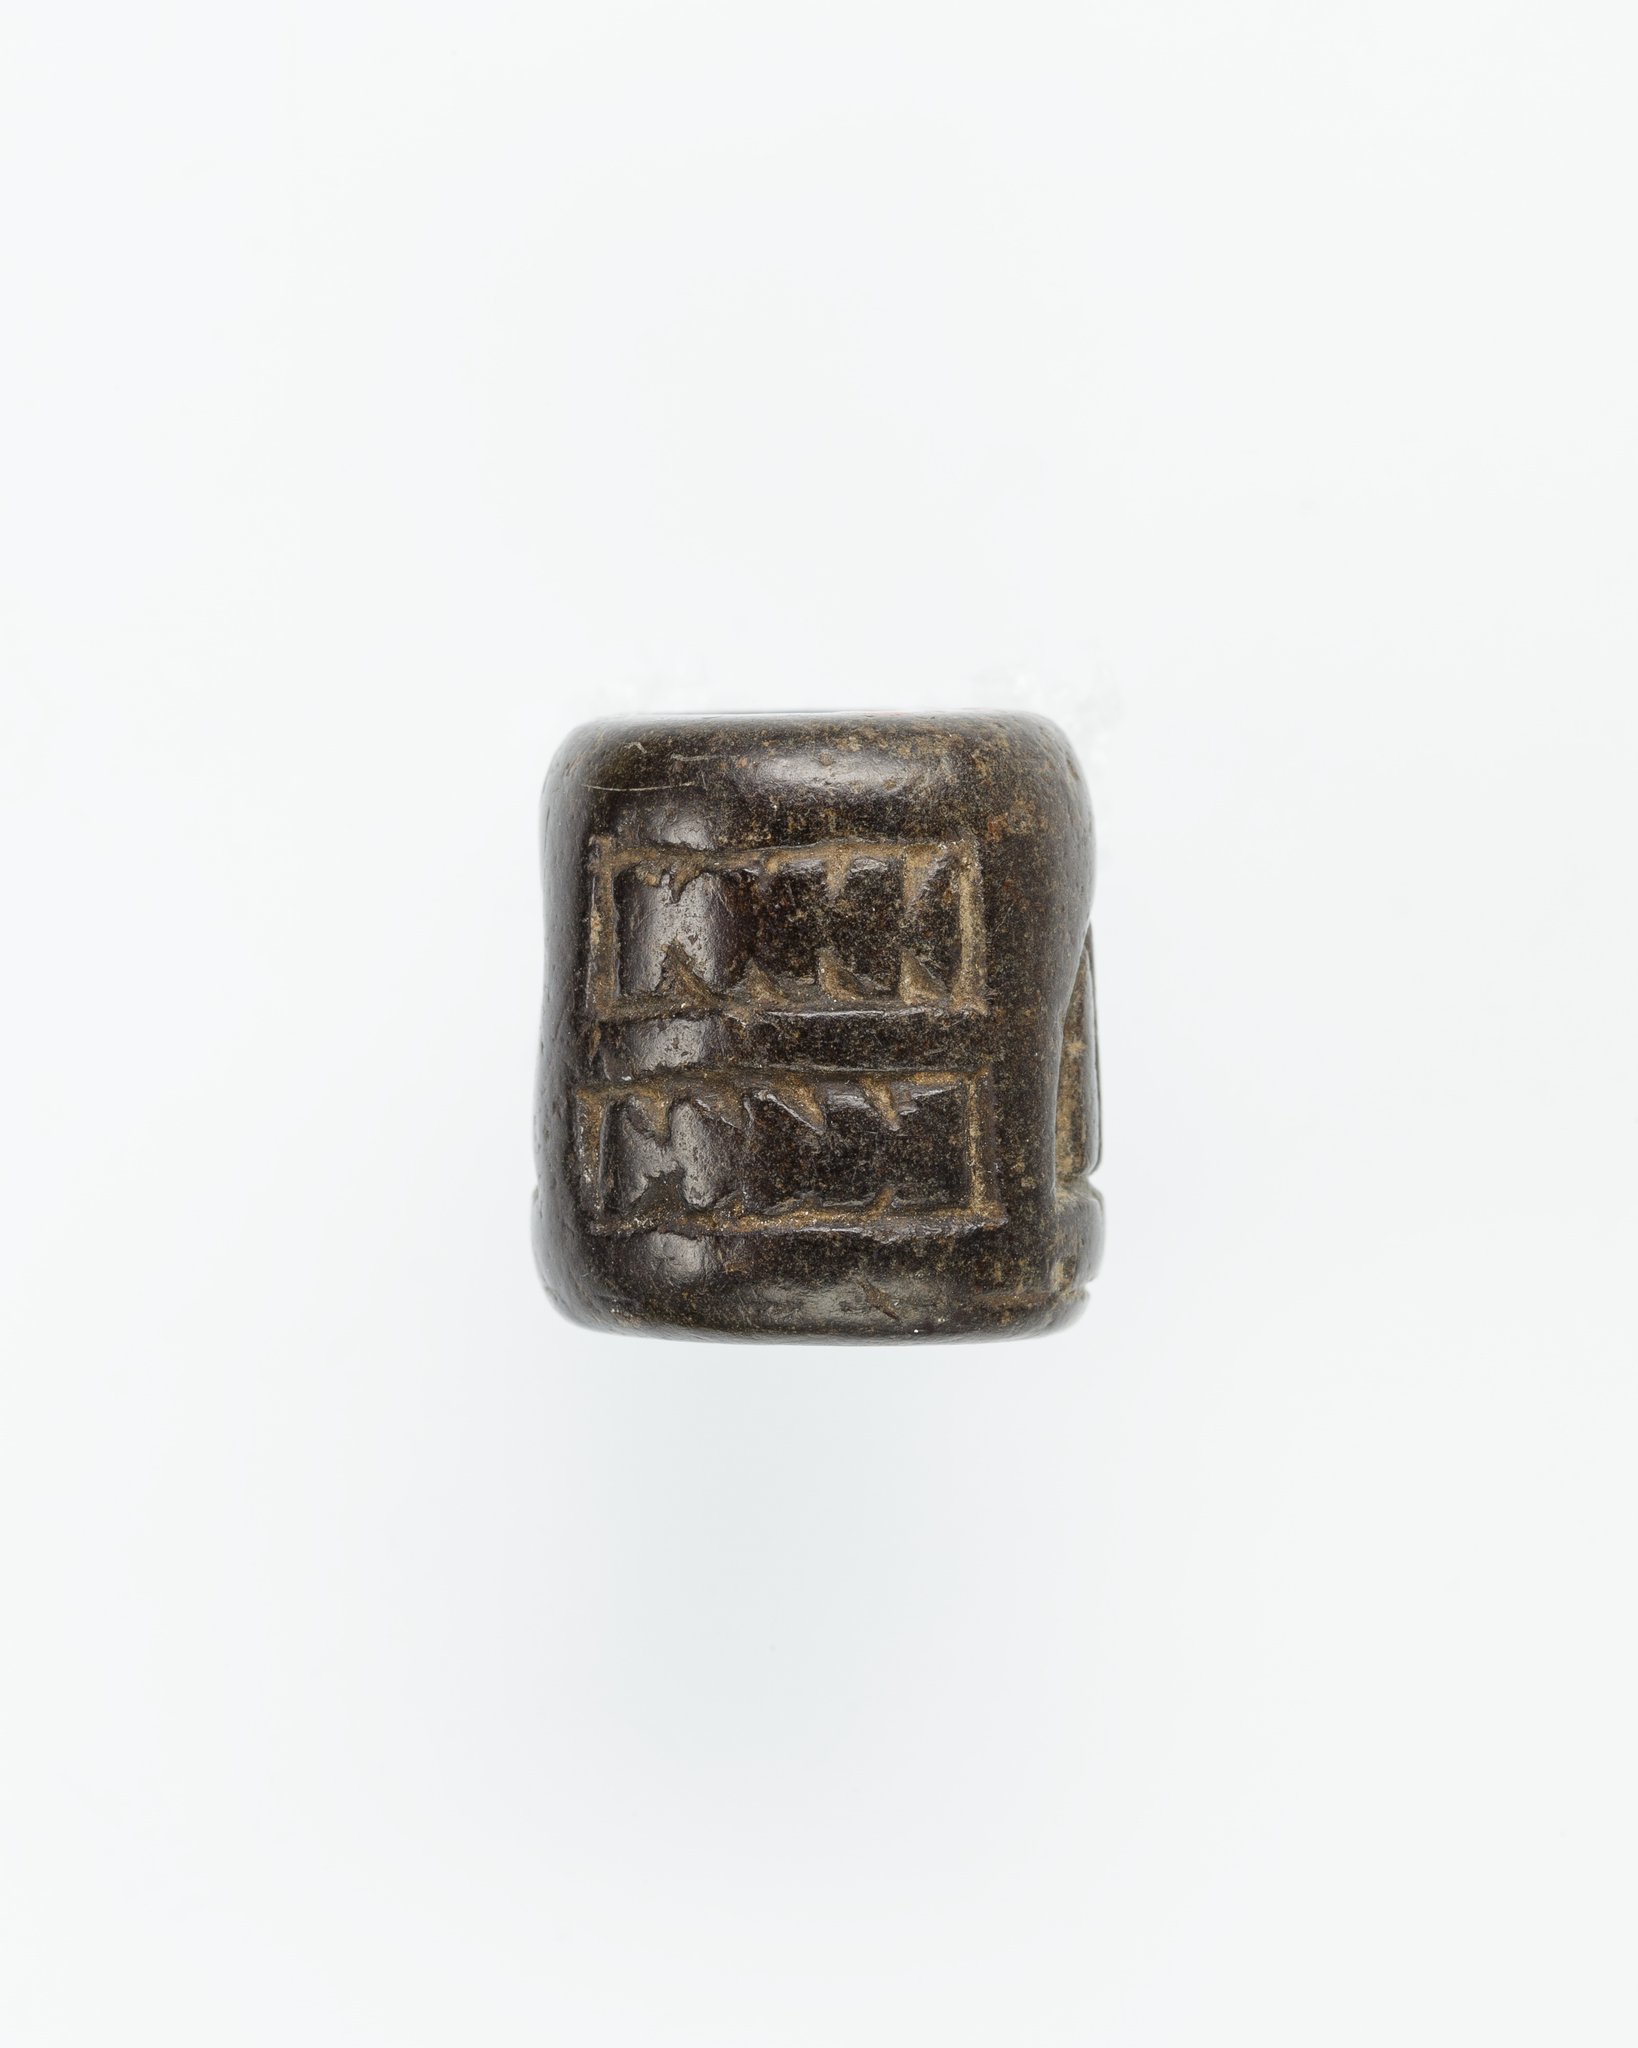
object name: cylinder seal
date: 2960-2649 BCE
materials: stone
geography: egypt